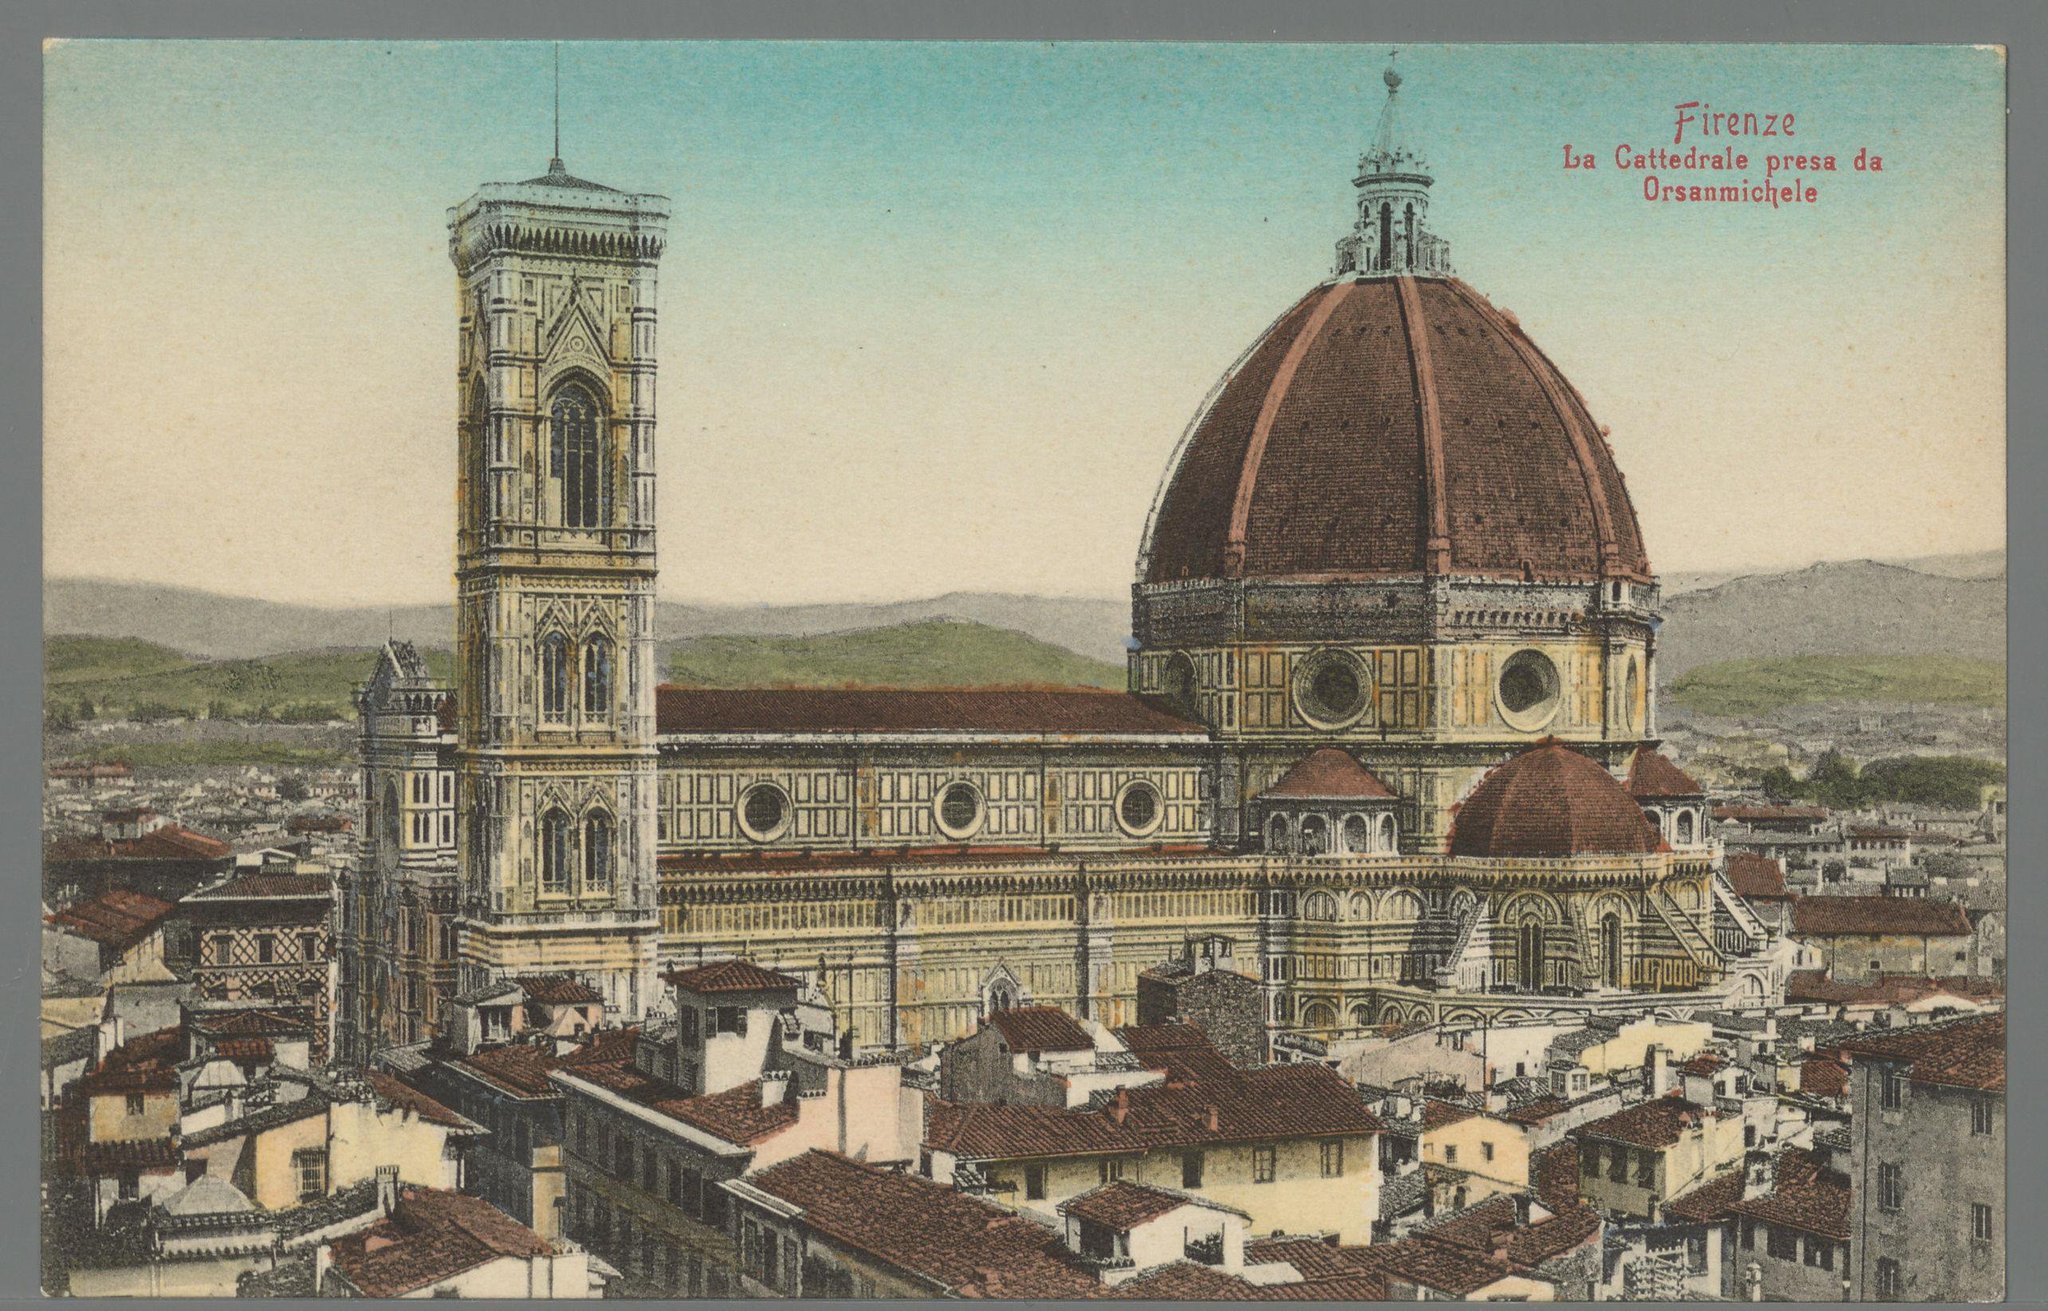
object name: ansichtkaart, prentbriefkaart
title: Firenze. La Cattedrale presa da Orsanmichele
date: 1905-1930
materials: cardboard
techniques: photograph, lithograph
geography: dresden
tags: city-view, and landscape with man-made constructions, church (exterior)